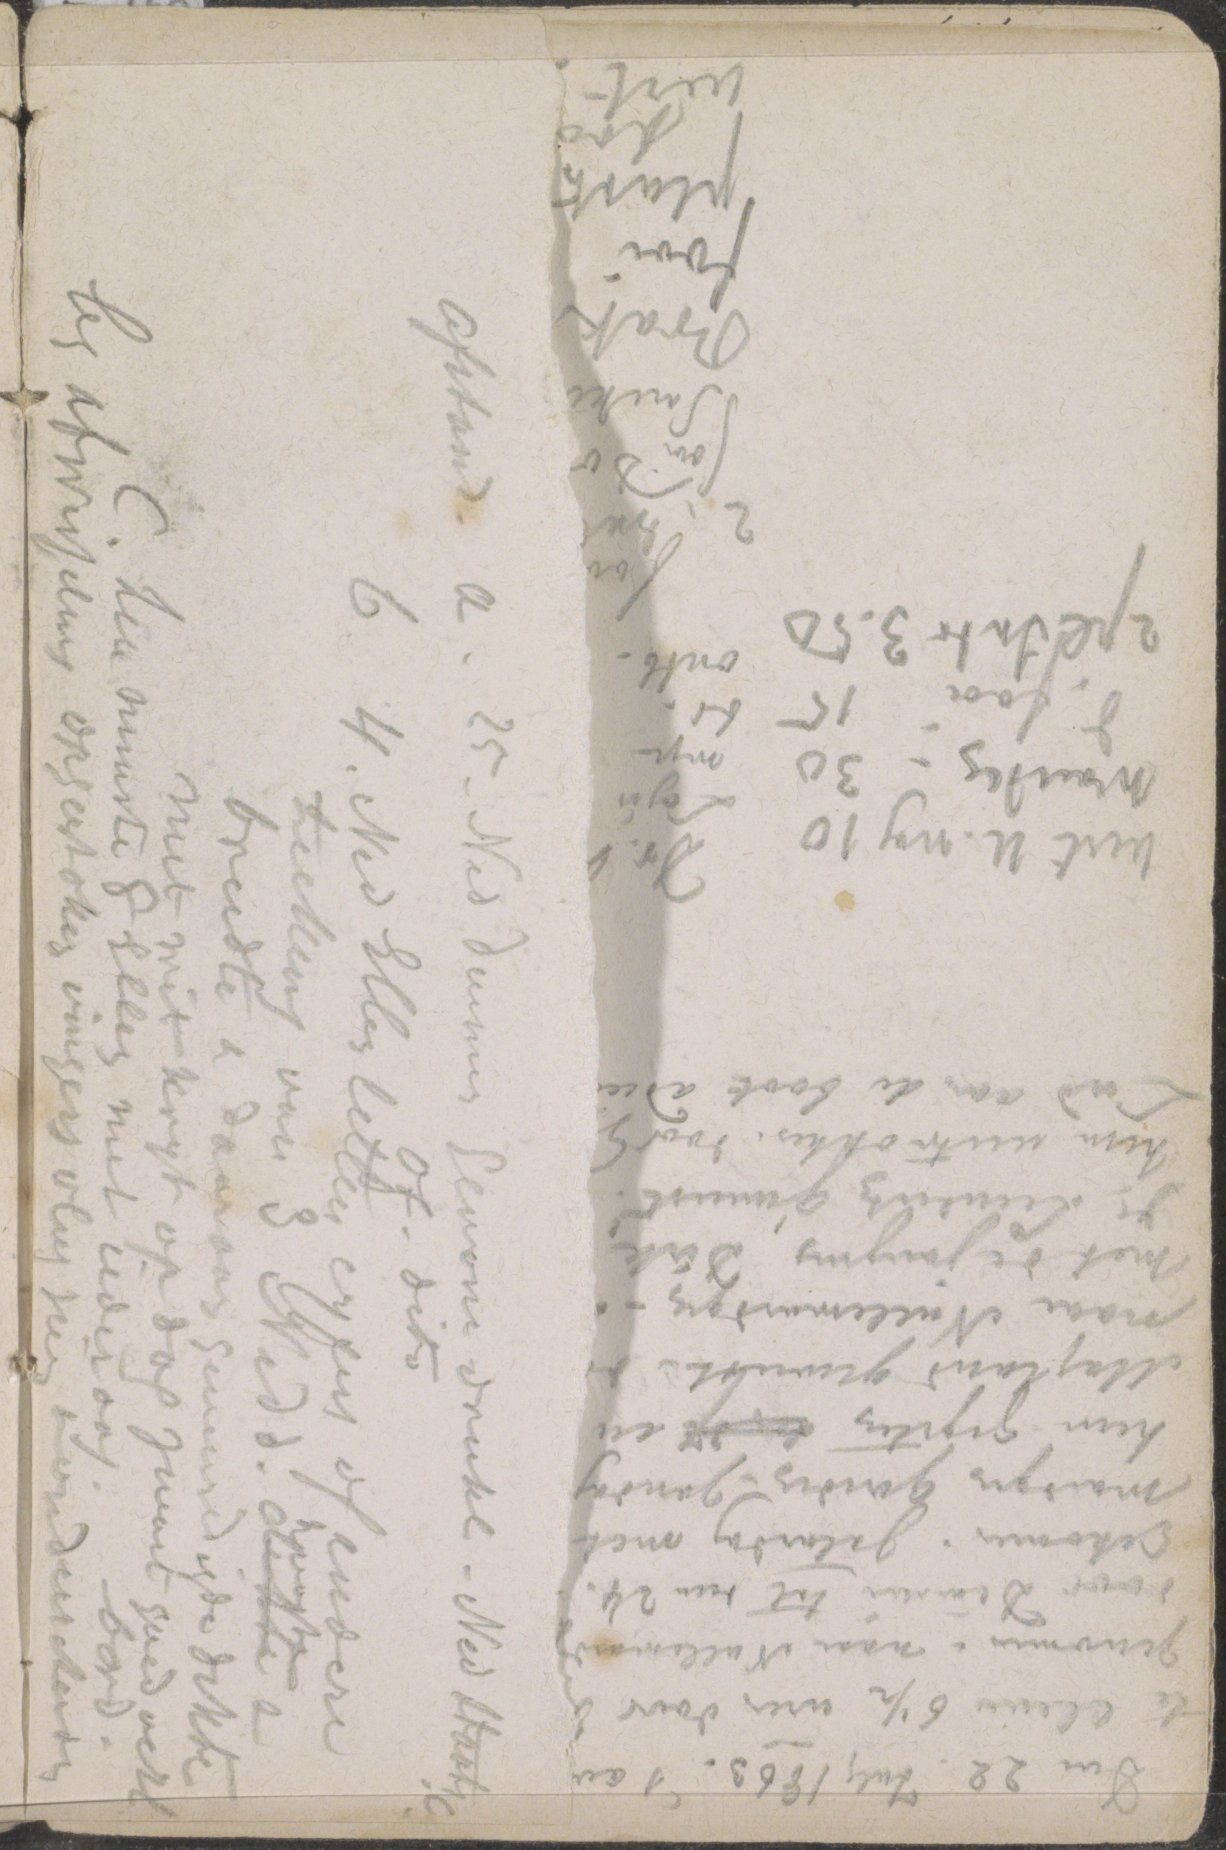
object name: sketchbook leaf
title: Notities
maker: johannes tavenraat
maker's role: draughtsman, painter, print maker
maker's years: 1809-1881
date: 1862-1864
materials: paper, pencil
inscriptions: annotation: ‘[...]’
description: Blad 58 recto uit een schetsboek met 65 bladen.